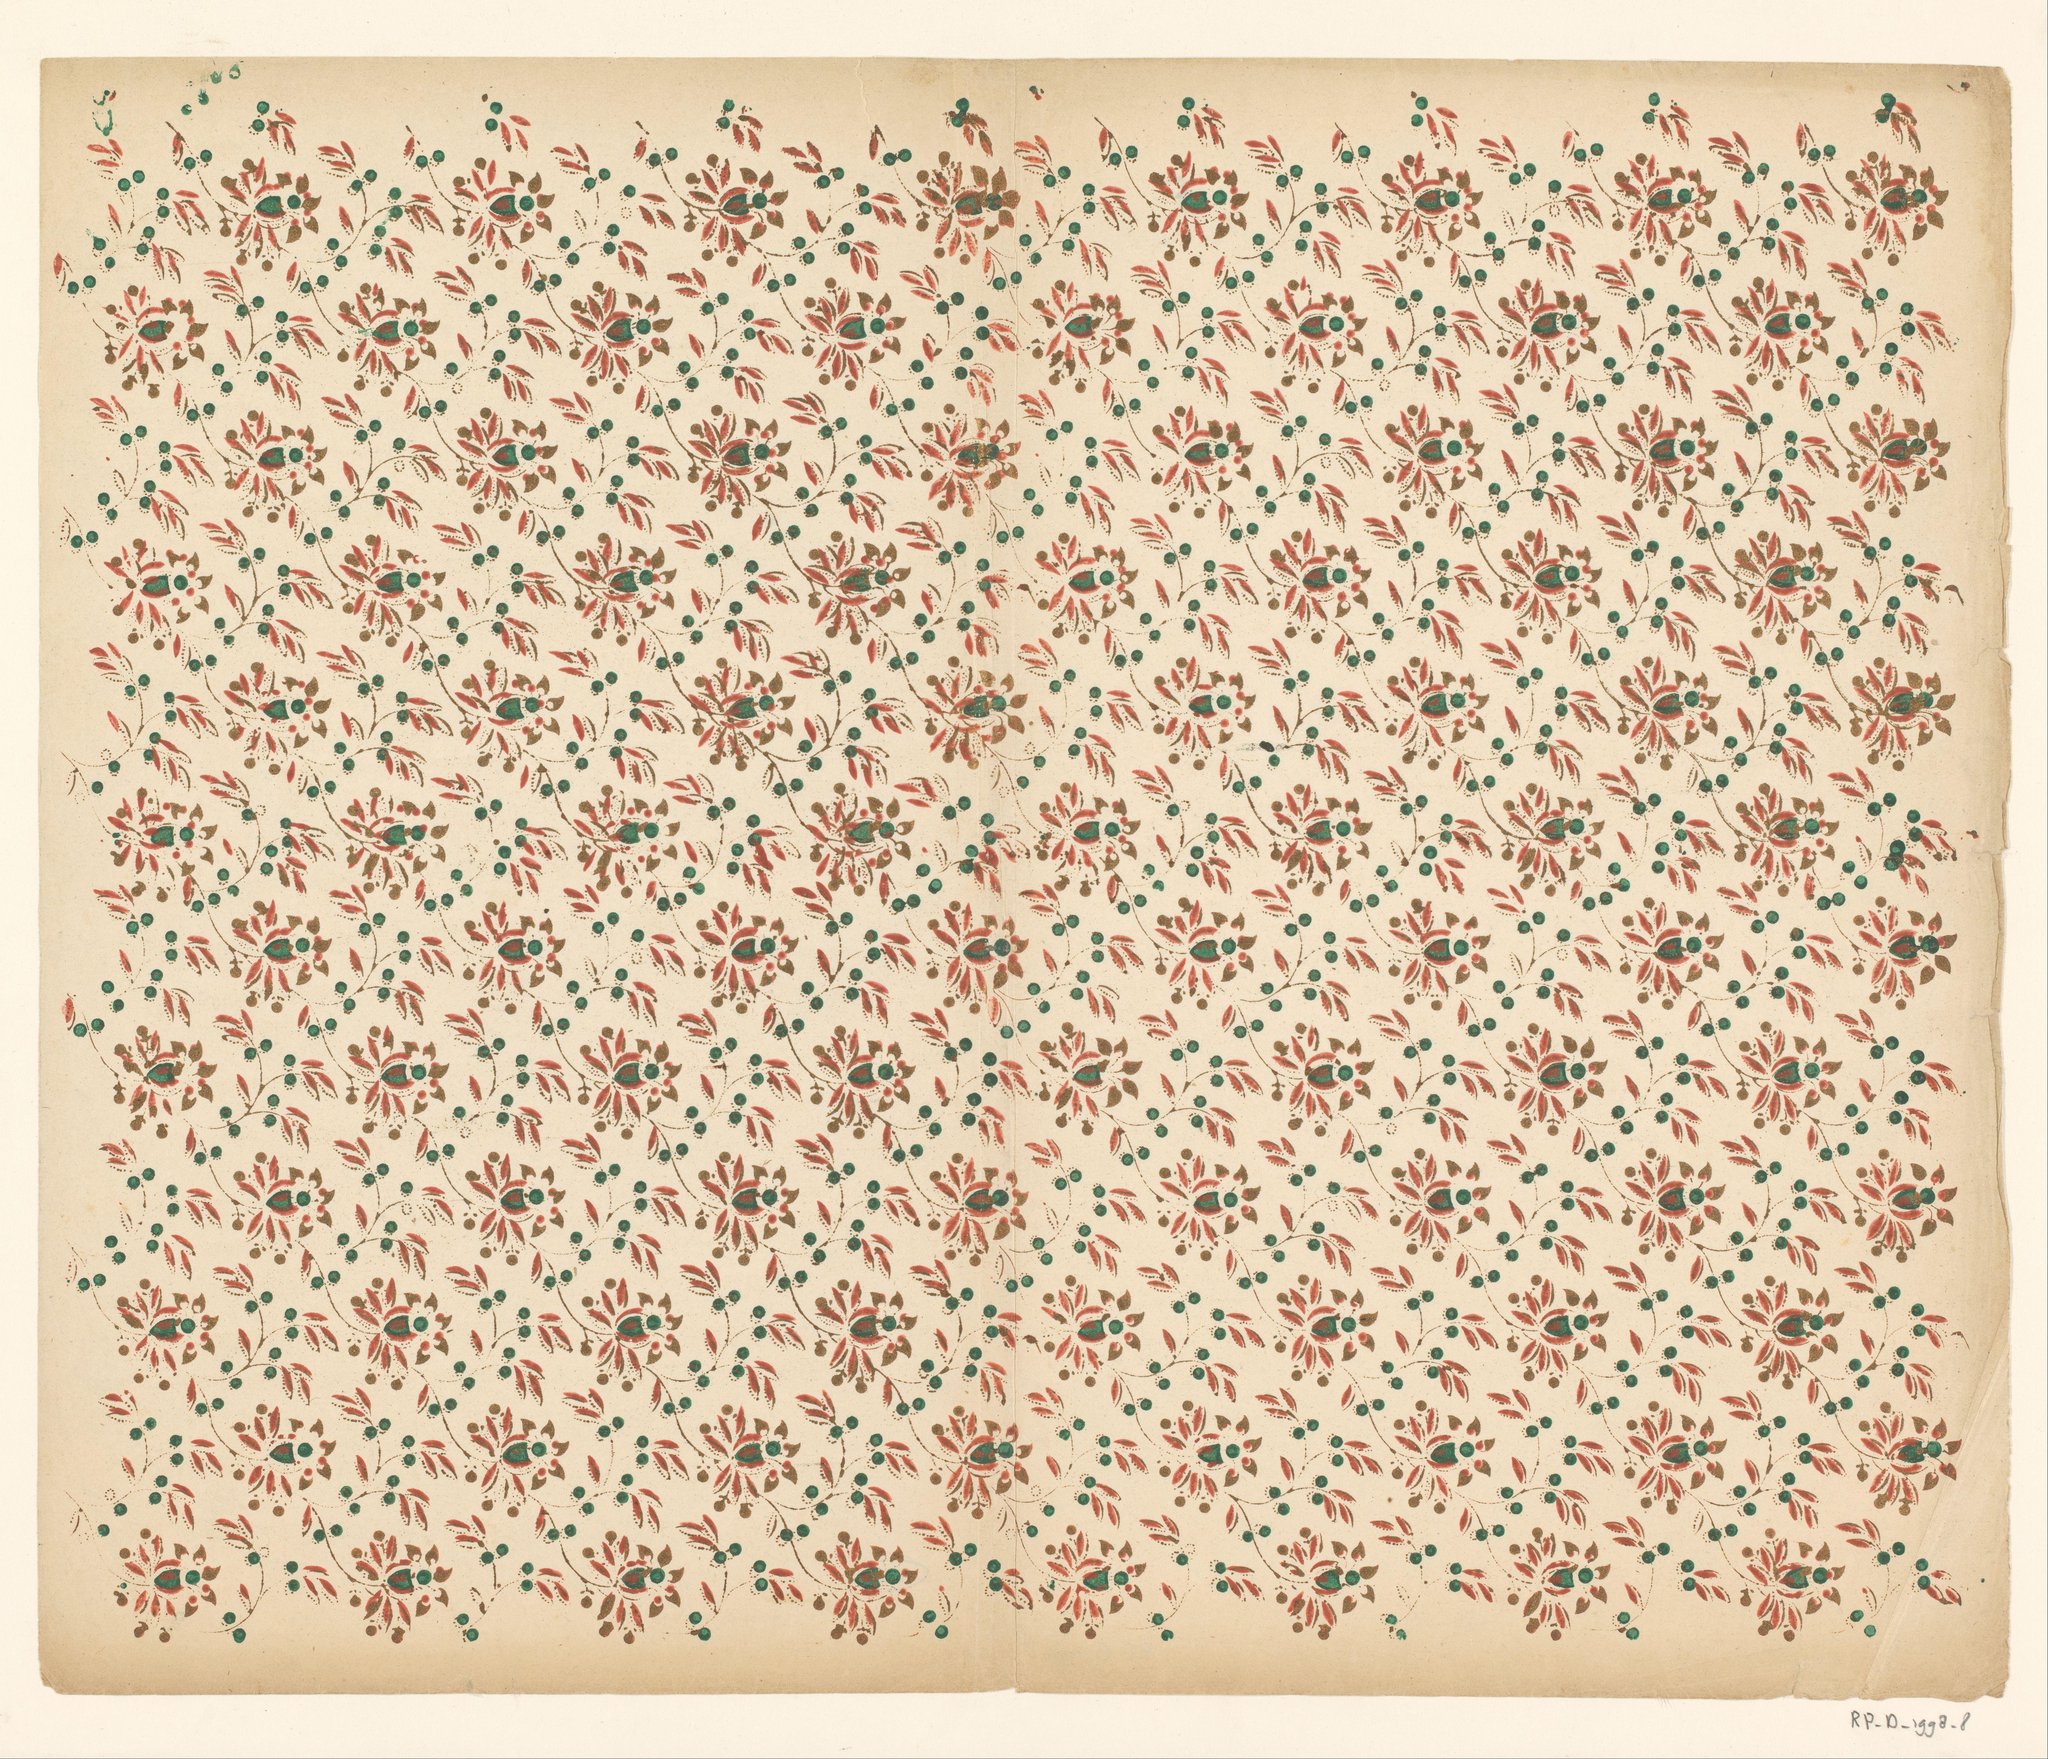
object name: printed paper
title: Blad met strooipatroon van ranken met bloemen, bladeren en vruchten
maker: Anonymous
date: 1800-1900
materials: paint, paper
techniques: printing block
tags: ornament derived from plant forms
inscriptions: collector's mark: Lugt 2228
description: Blad met strooipatroon van ranken met bloemen, bladeren en vruchten.